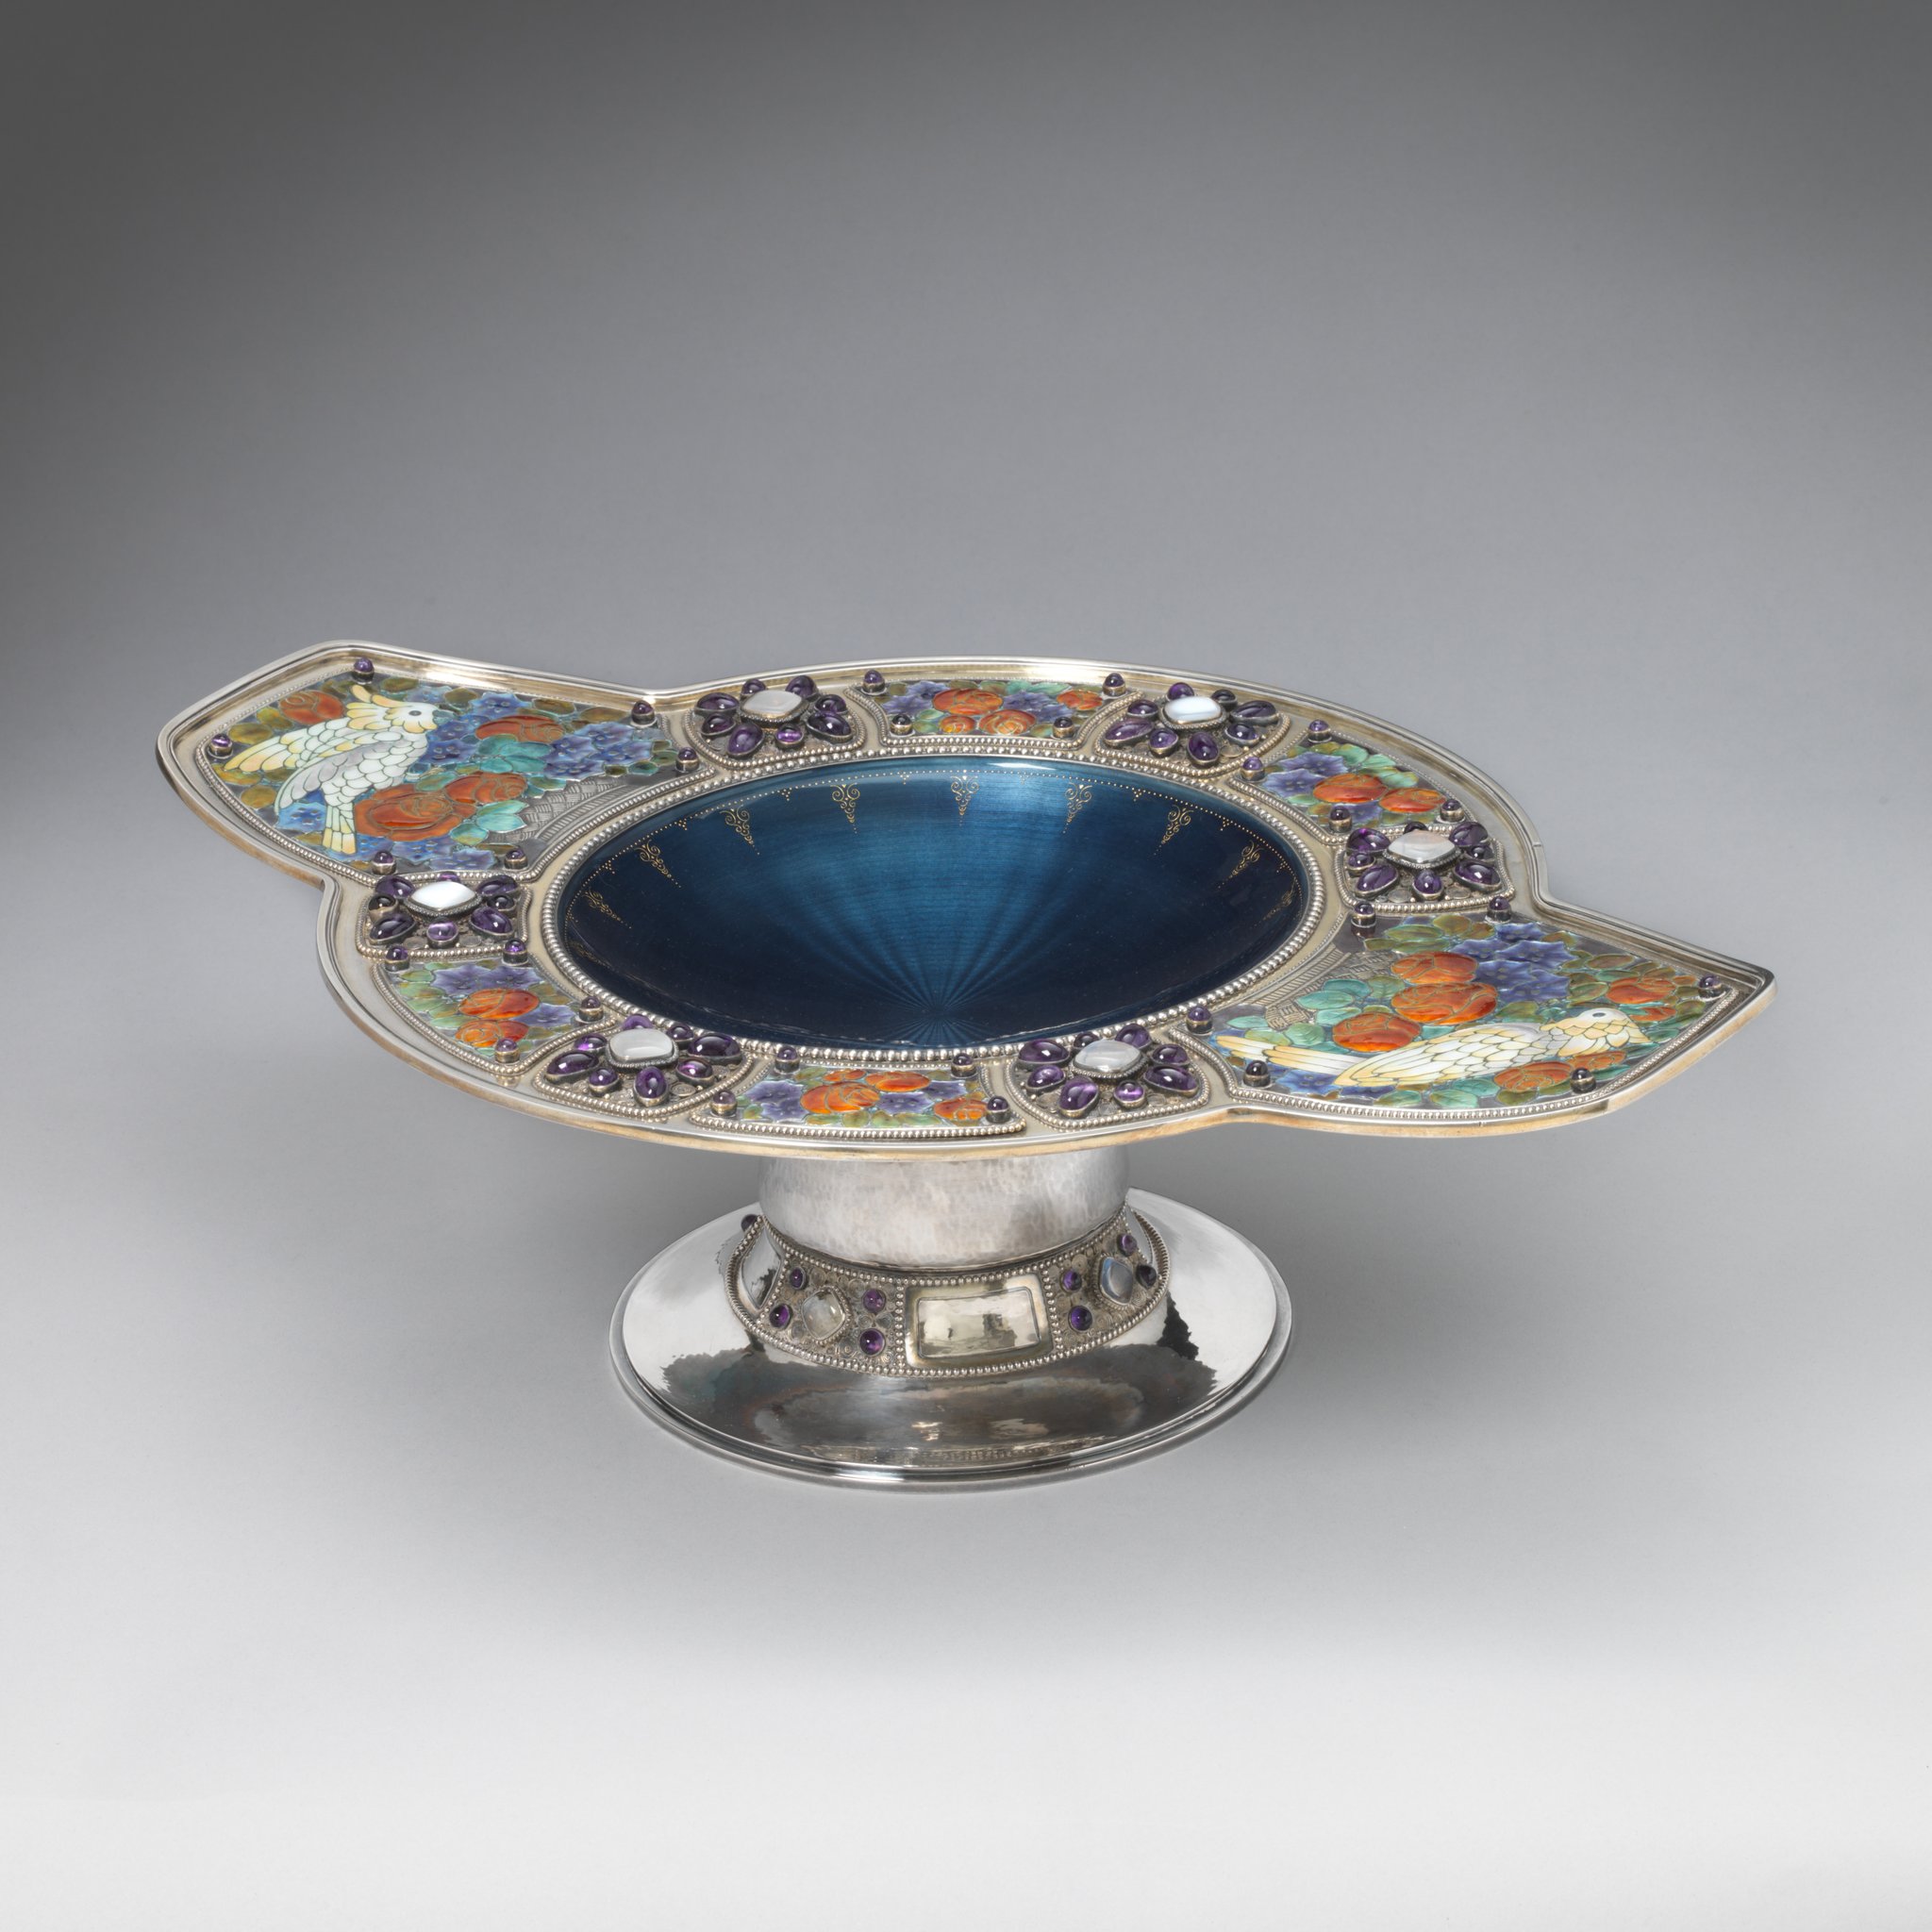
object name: compote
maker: david andersen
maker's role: maker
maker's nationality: norwegian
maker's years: 1843-1901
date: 1900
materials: gemstone, enamel, gold, silver, metal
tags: birds